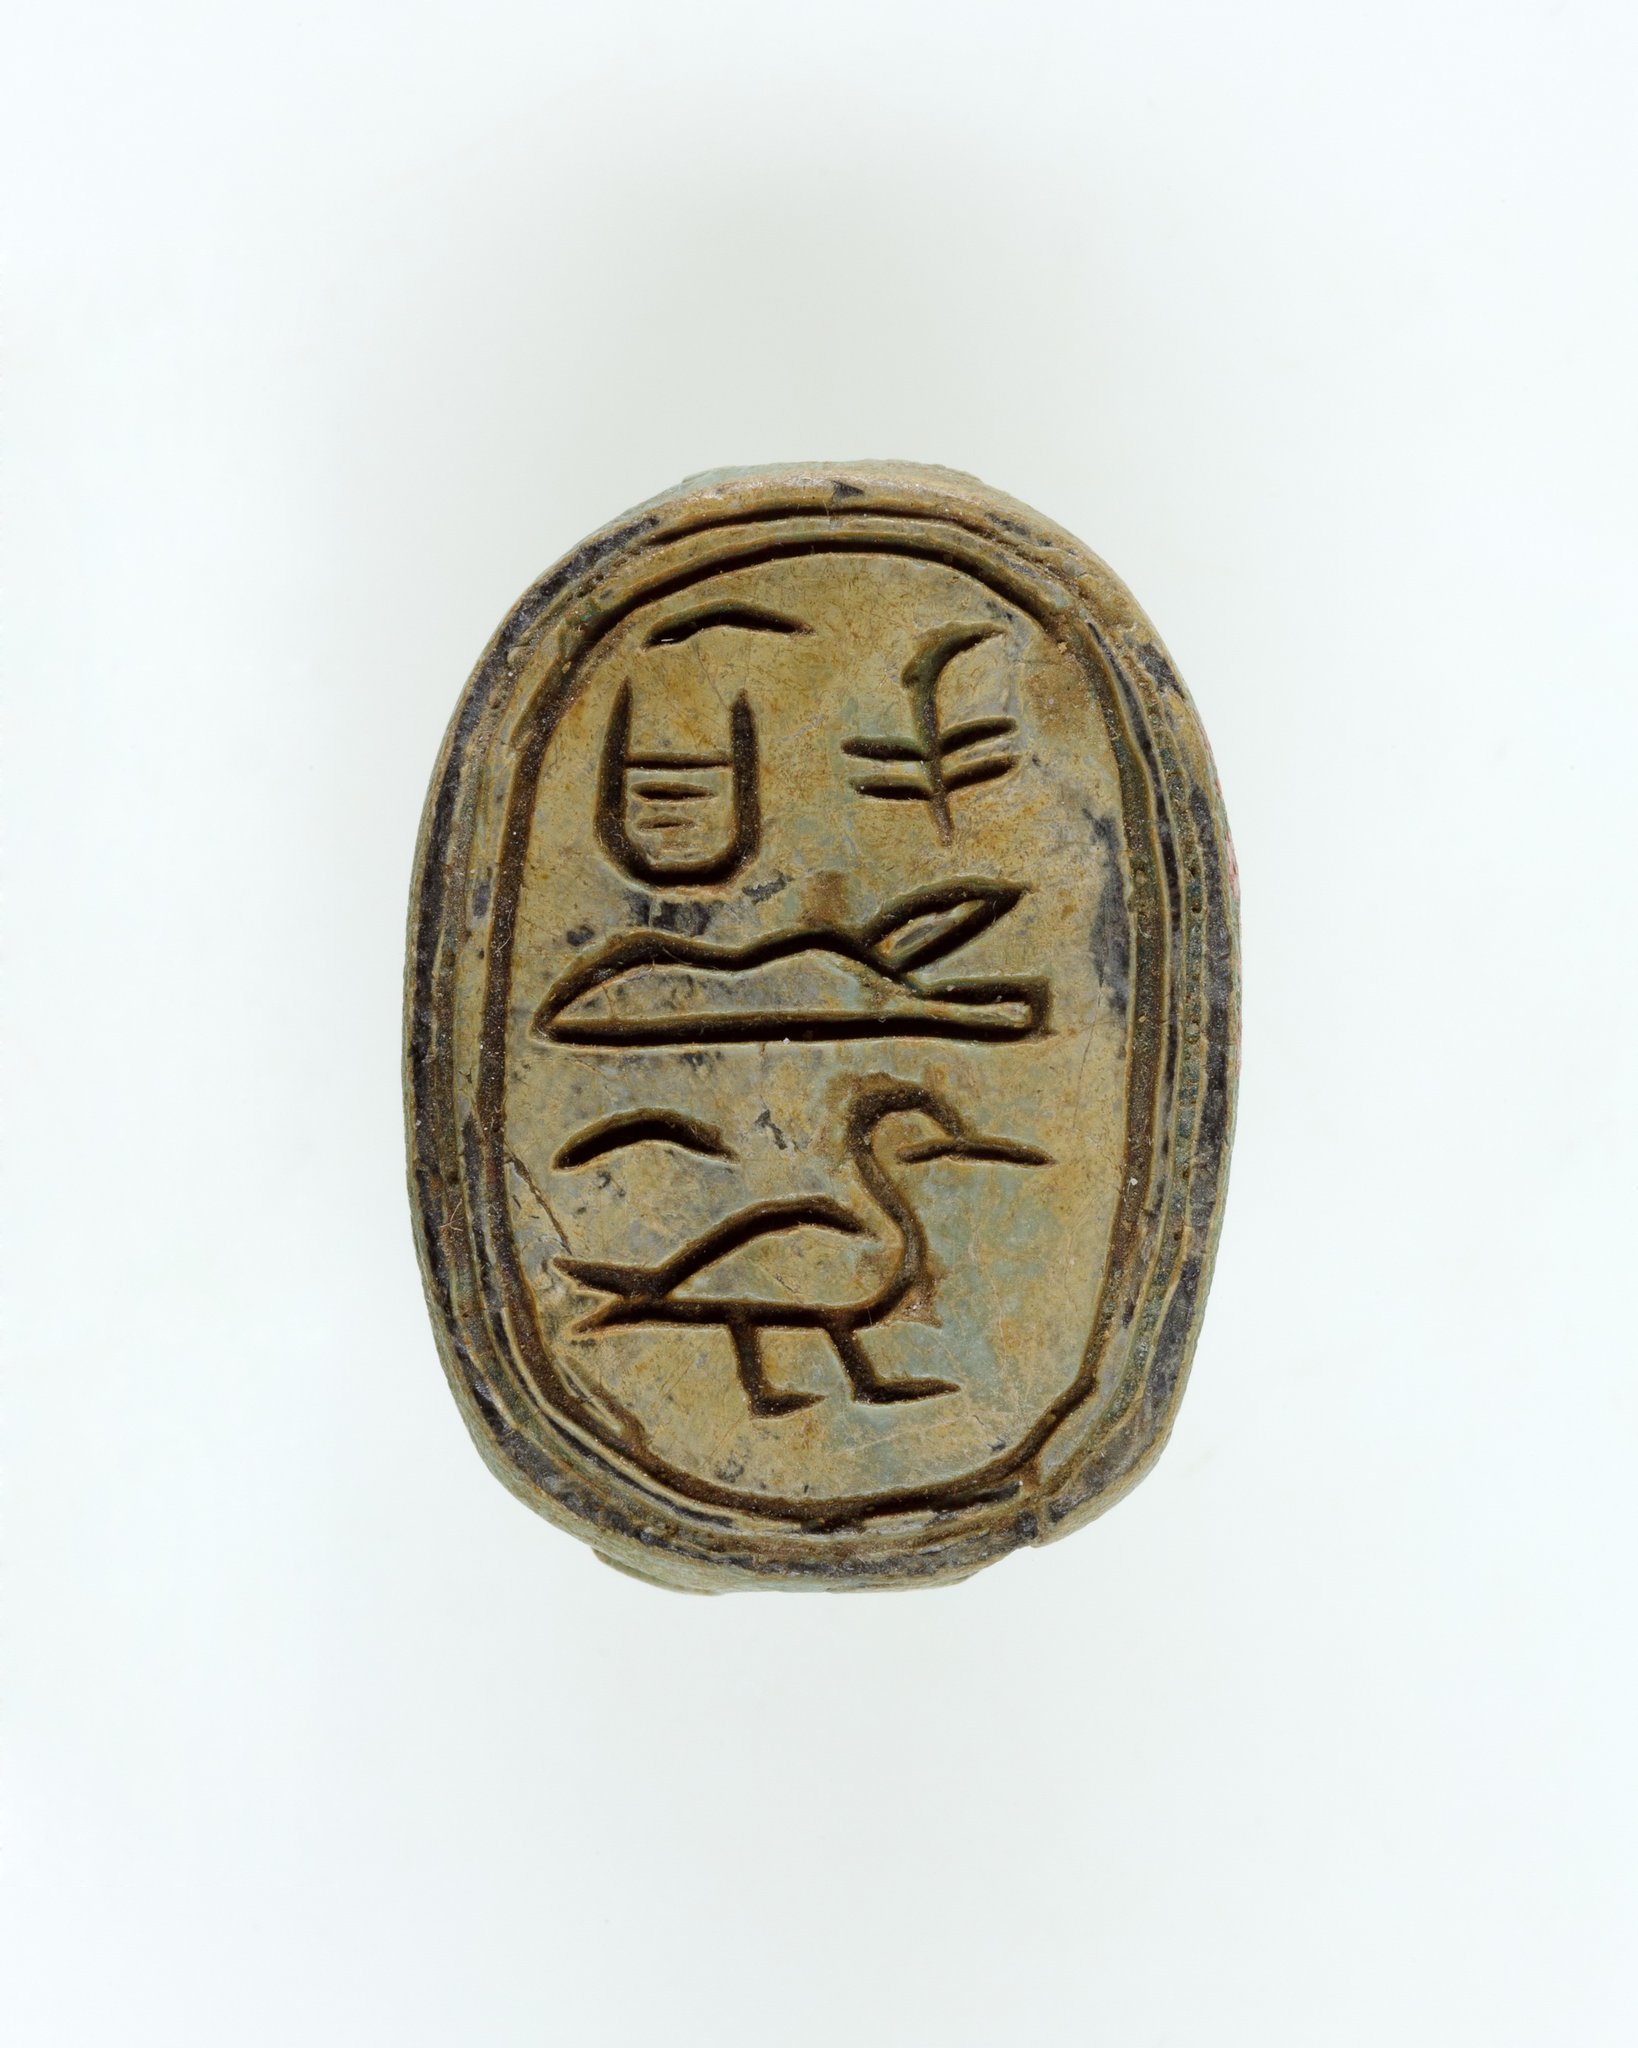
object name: scarab, queen sitsebek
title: Scarab of Queen Sitsebek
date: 1802-1640 BCE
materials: glaze, stone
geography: egypt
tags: hieroglyphs,scarabs